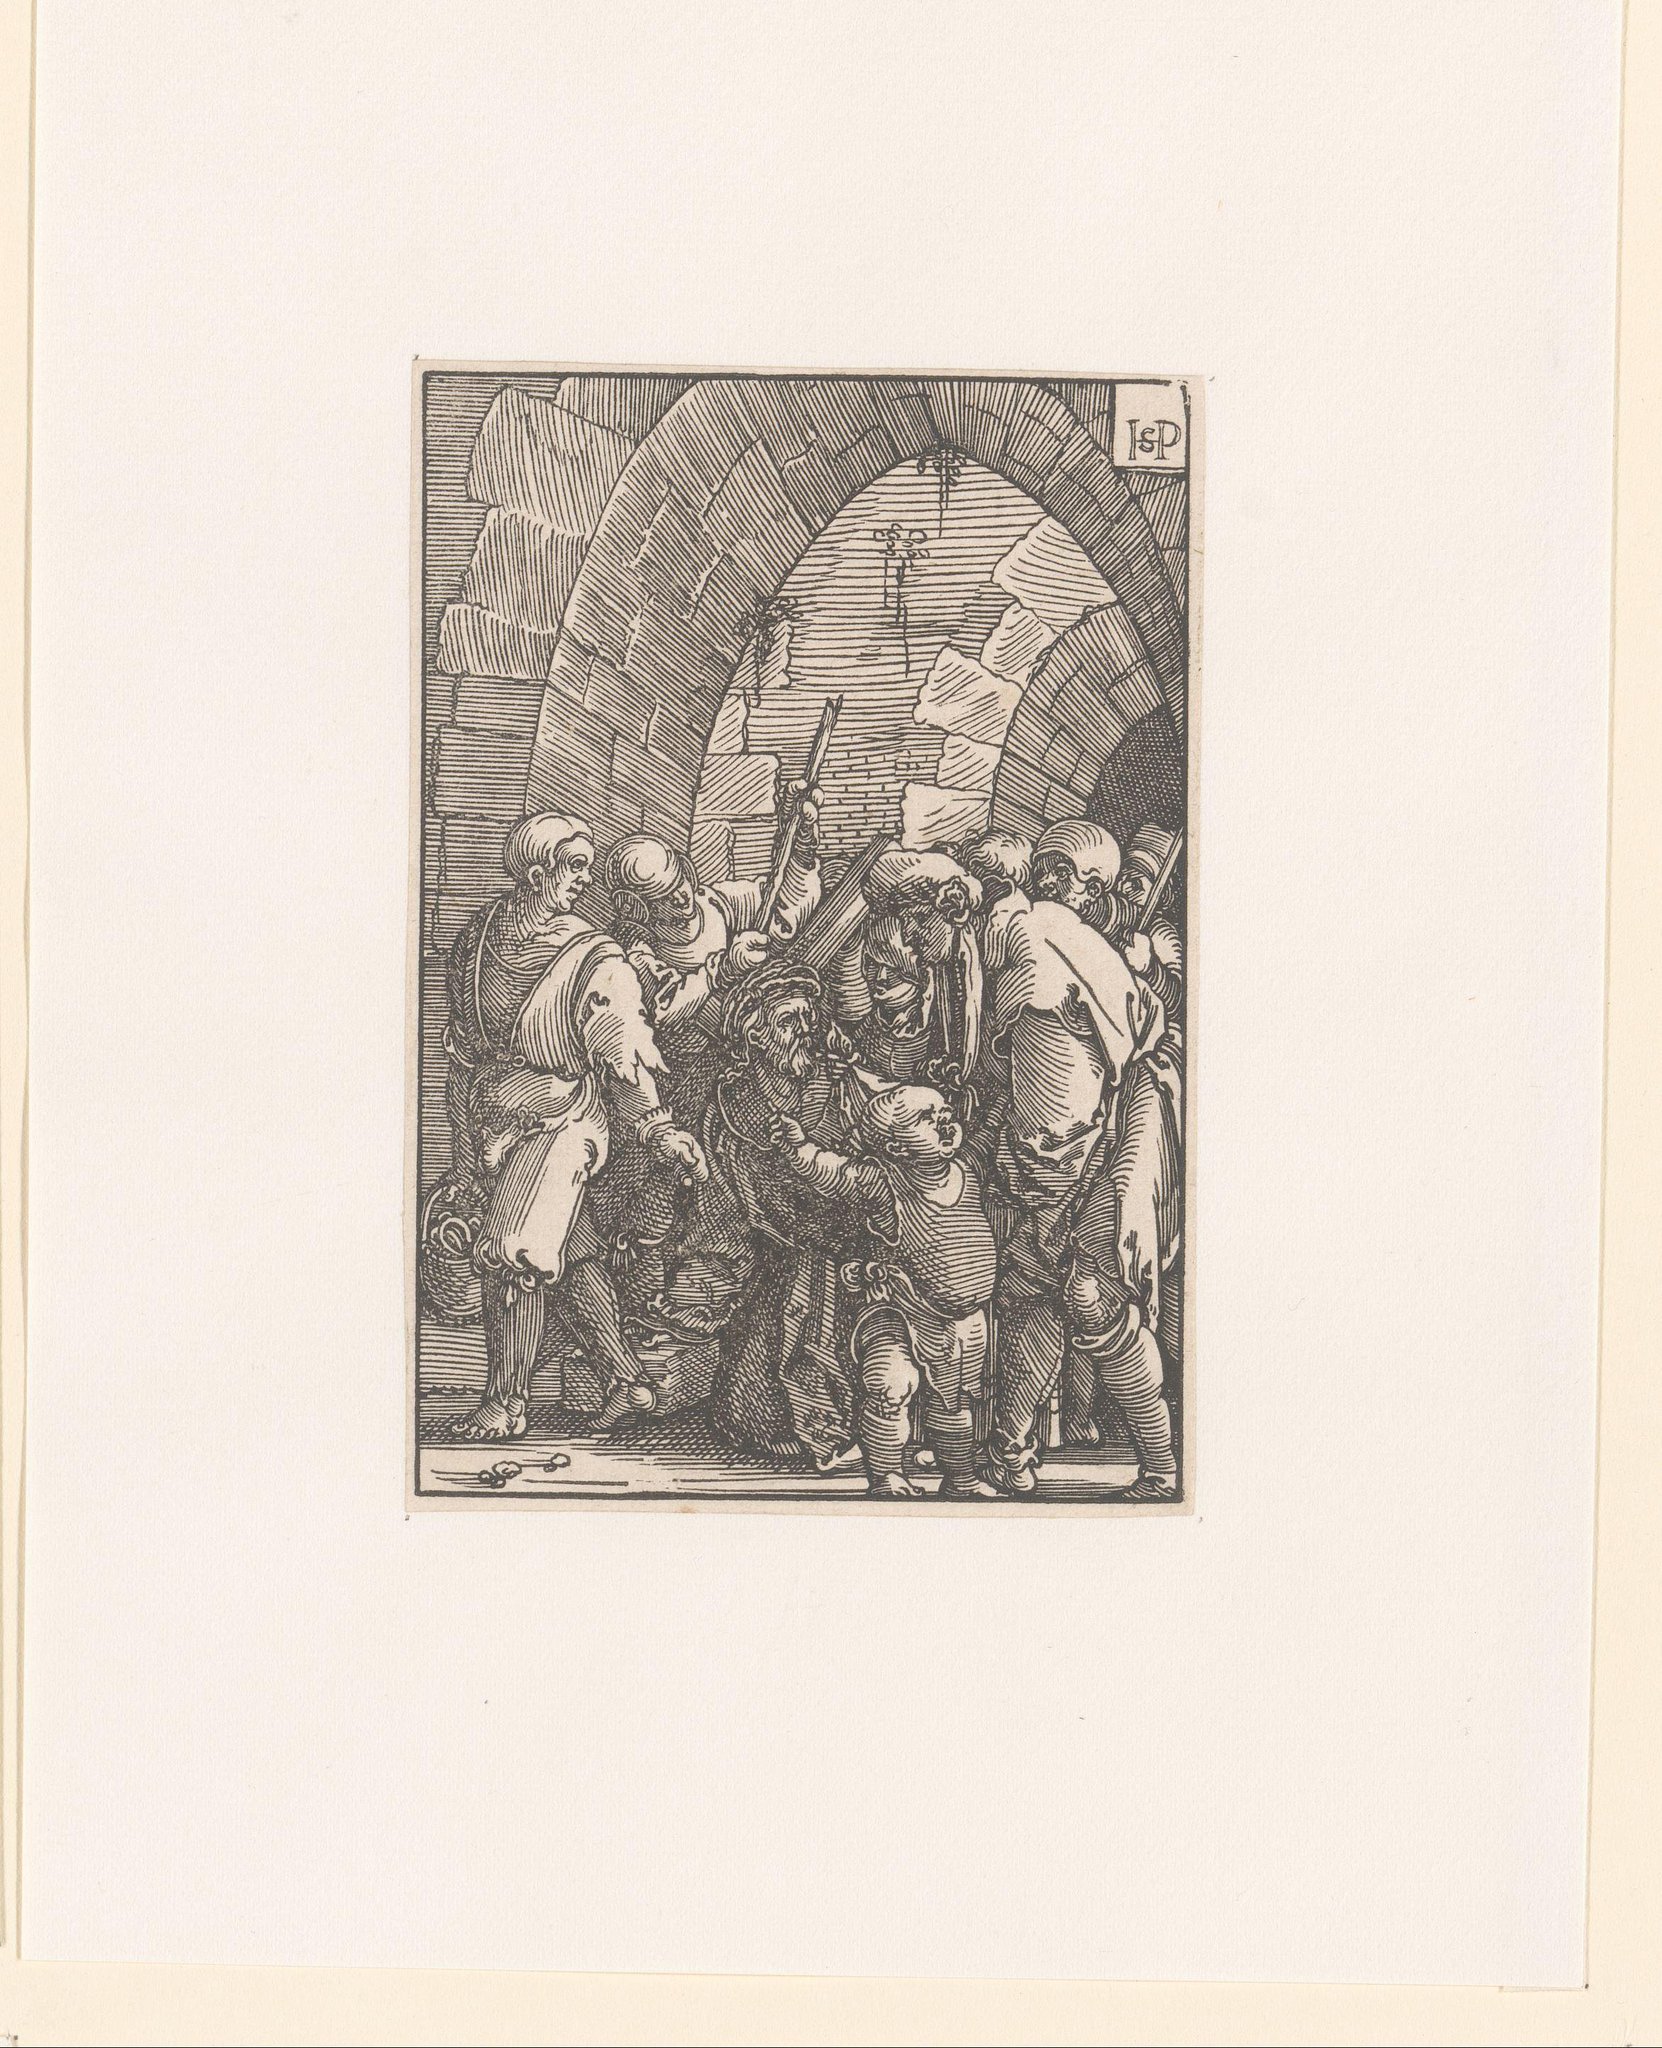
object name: print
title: Kruisdraging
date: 1521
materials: paper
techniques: woodcut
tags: stations of the cross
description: Onderdeel van een serie van acht prenten met de passie van Christus.